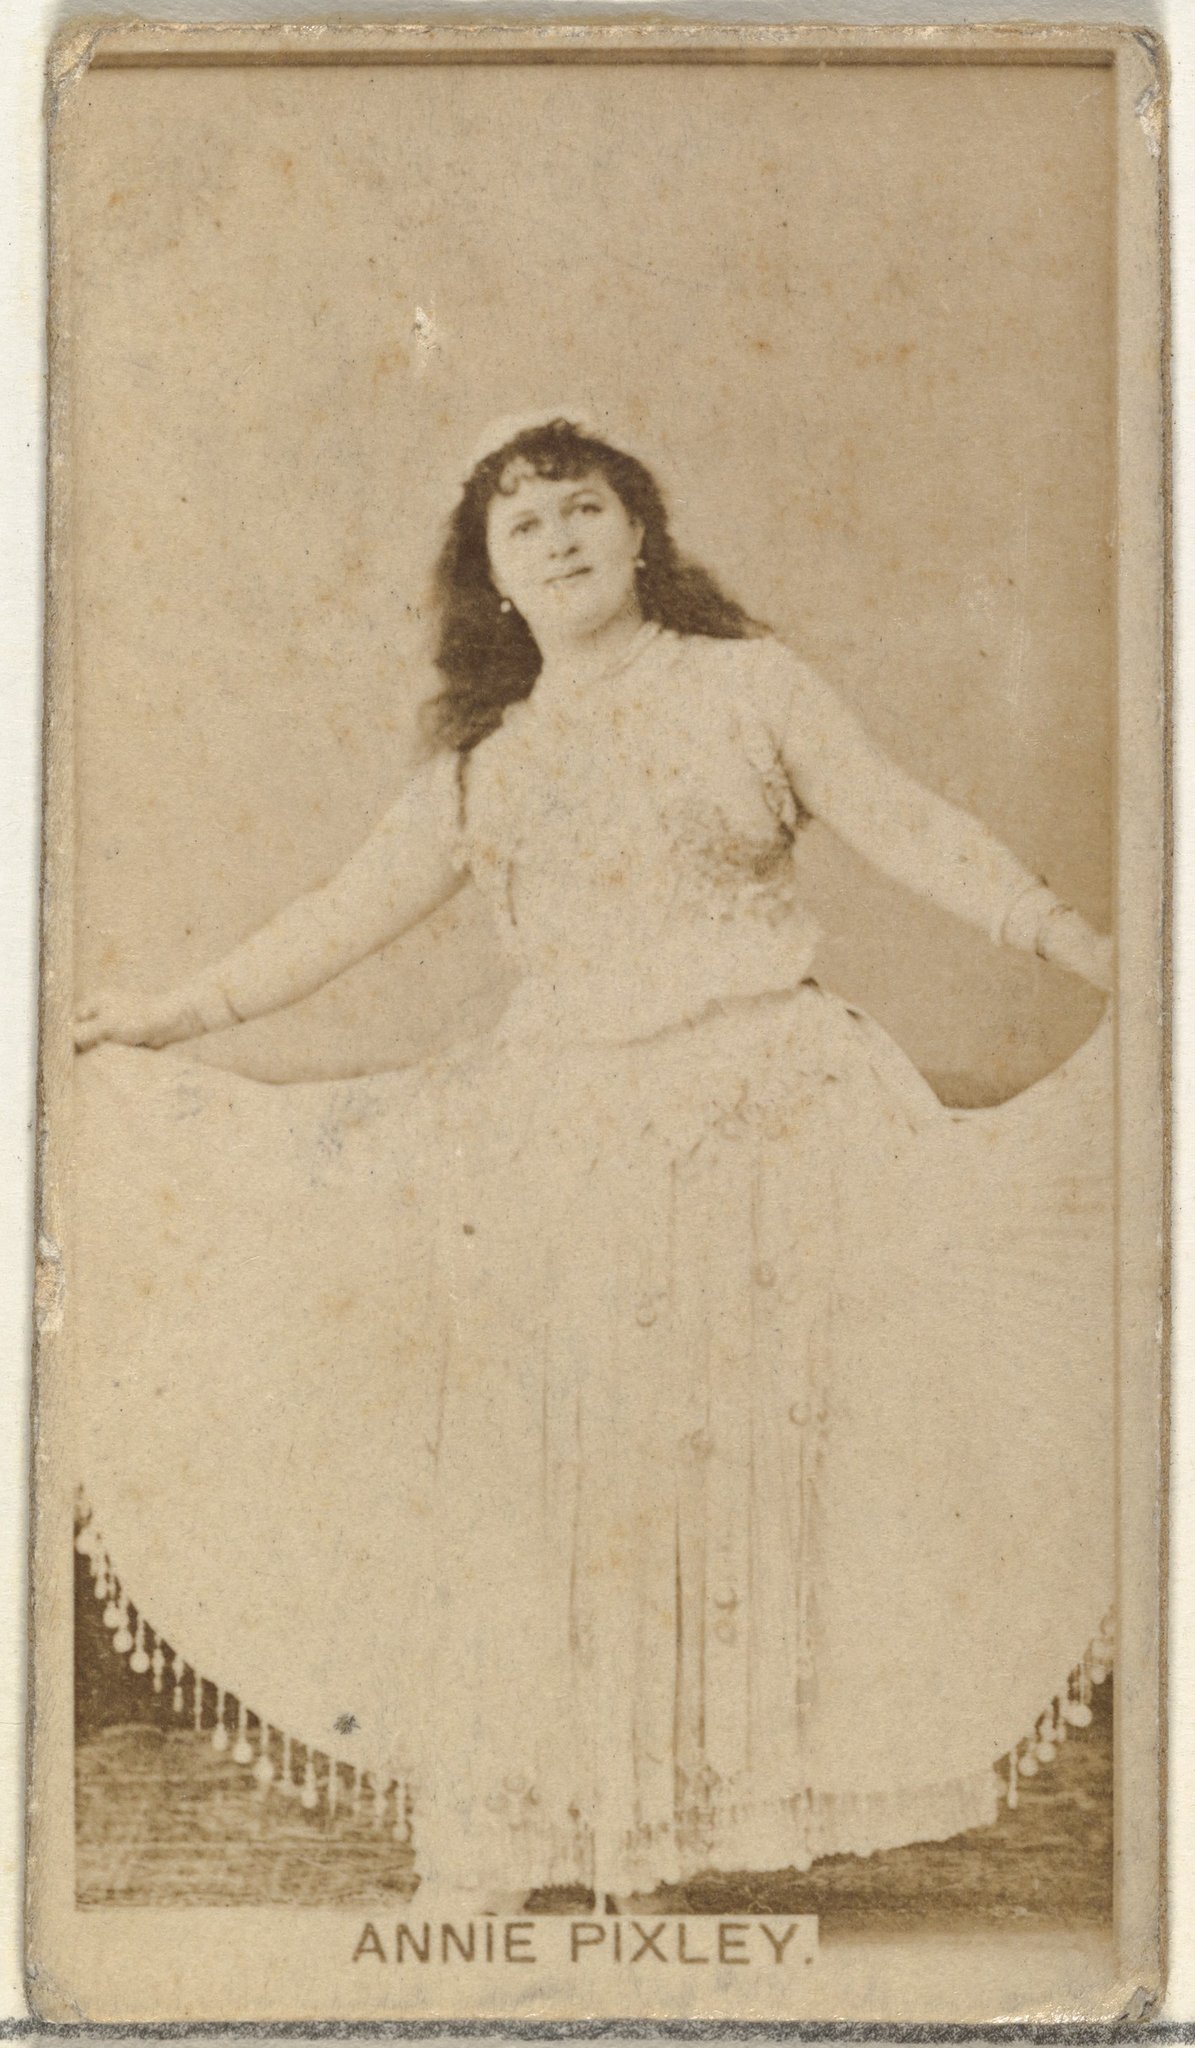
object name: photograph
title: Annie Pixley, from the Actors and Actresses series (N145-8) issued by Duke Sons & Co. to promote Duke Cigarettes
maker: w. duke, sons & co.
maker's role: publisher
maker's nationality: american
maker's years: 1870-1920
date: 1891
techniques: albumen silver print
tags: portraits,women,actresses